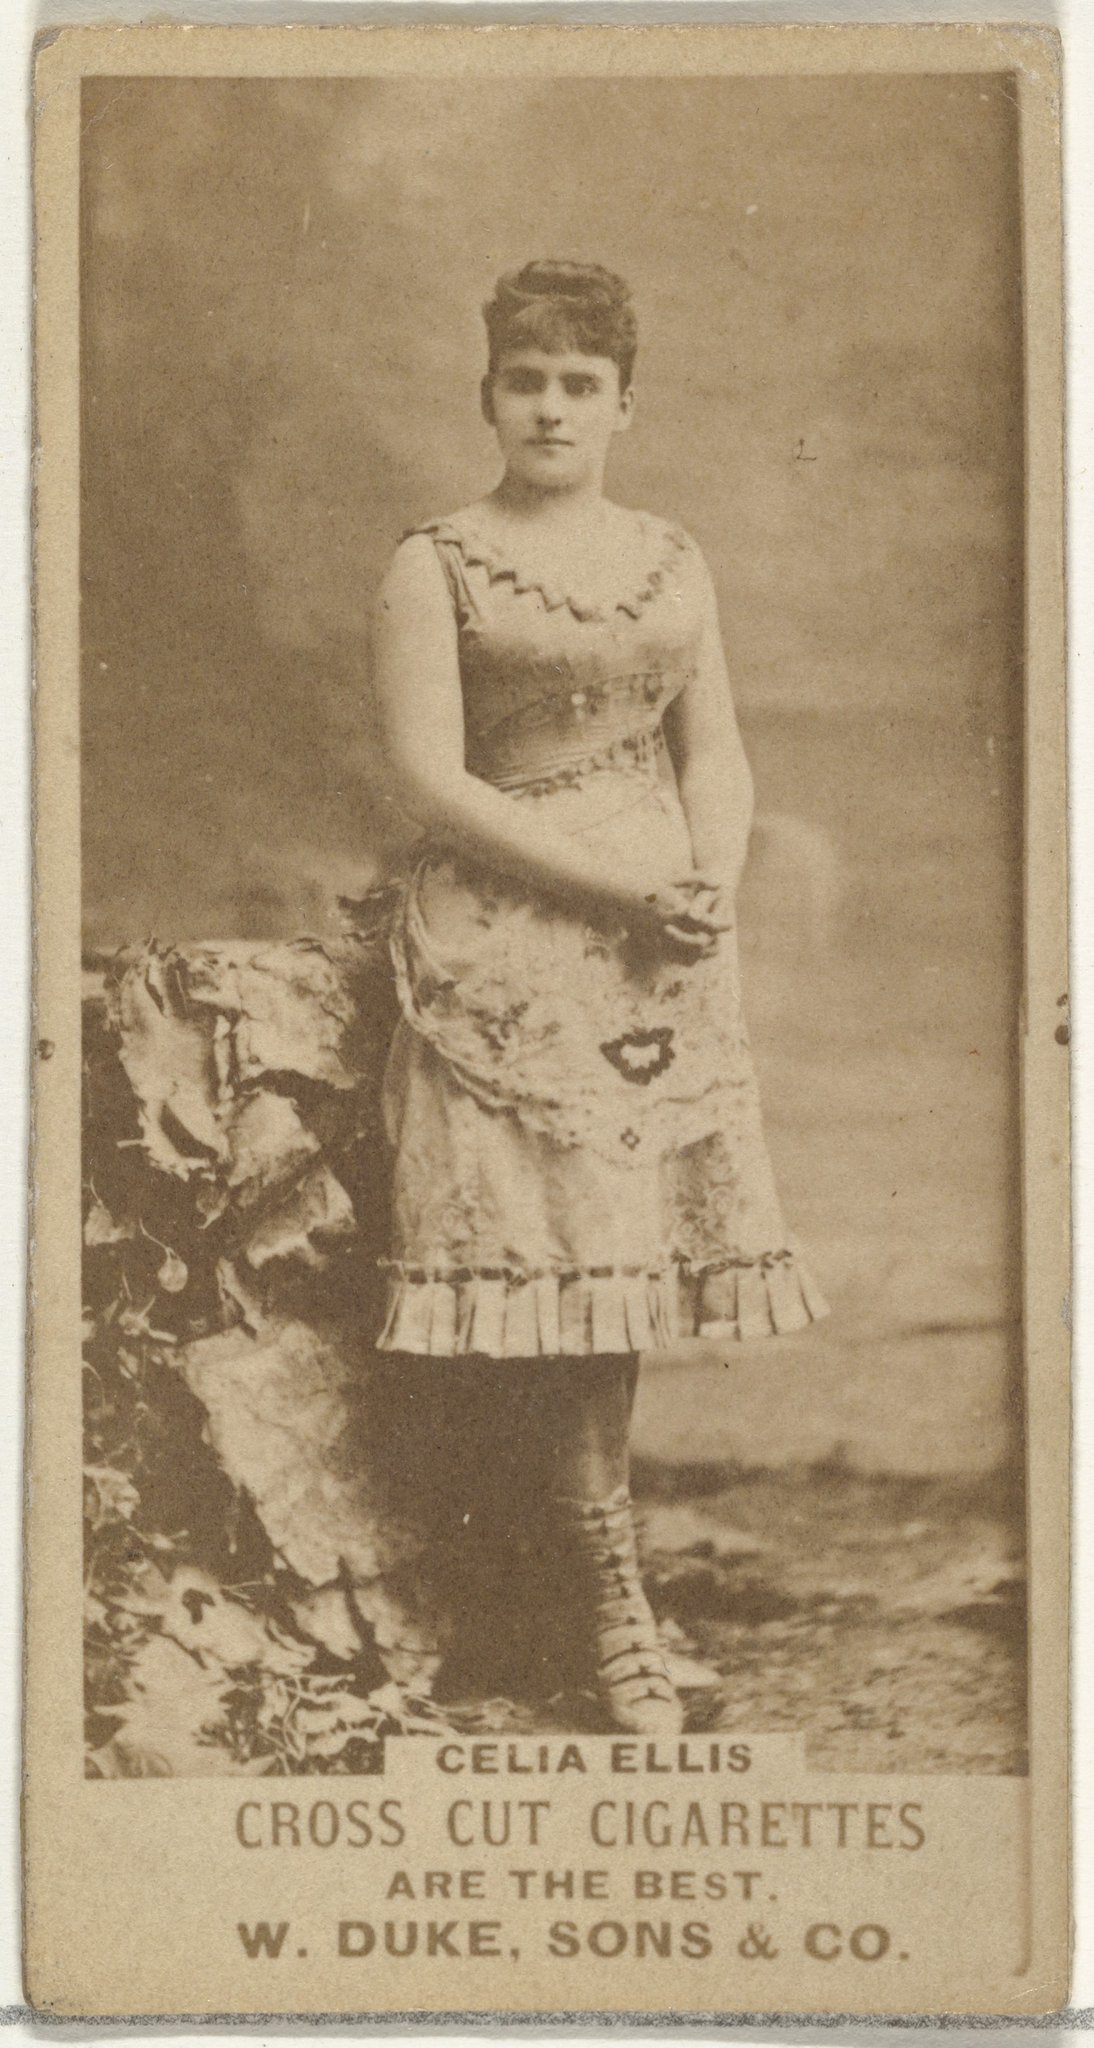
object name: photograph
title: Celia Ellis, from the Actors and Actresses series (N145-3) issued by Duke Sons & Co. to promote Cross Cut Cigarettes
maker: w. duke, sons & co.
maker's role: publisher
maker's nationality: american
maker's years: 1870-1920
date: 1880-1889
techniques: albumen silver print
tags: portraits,women,actresses